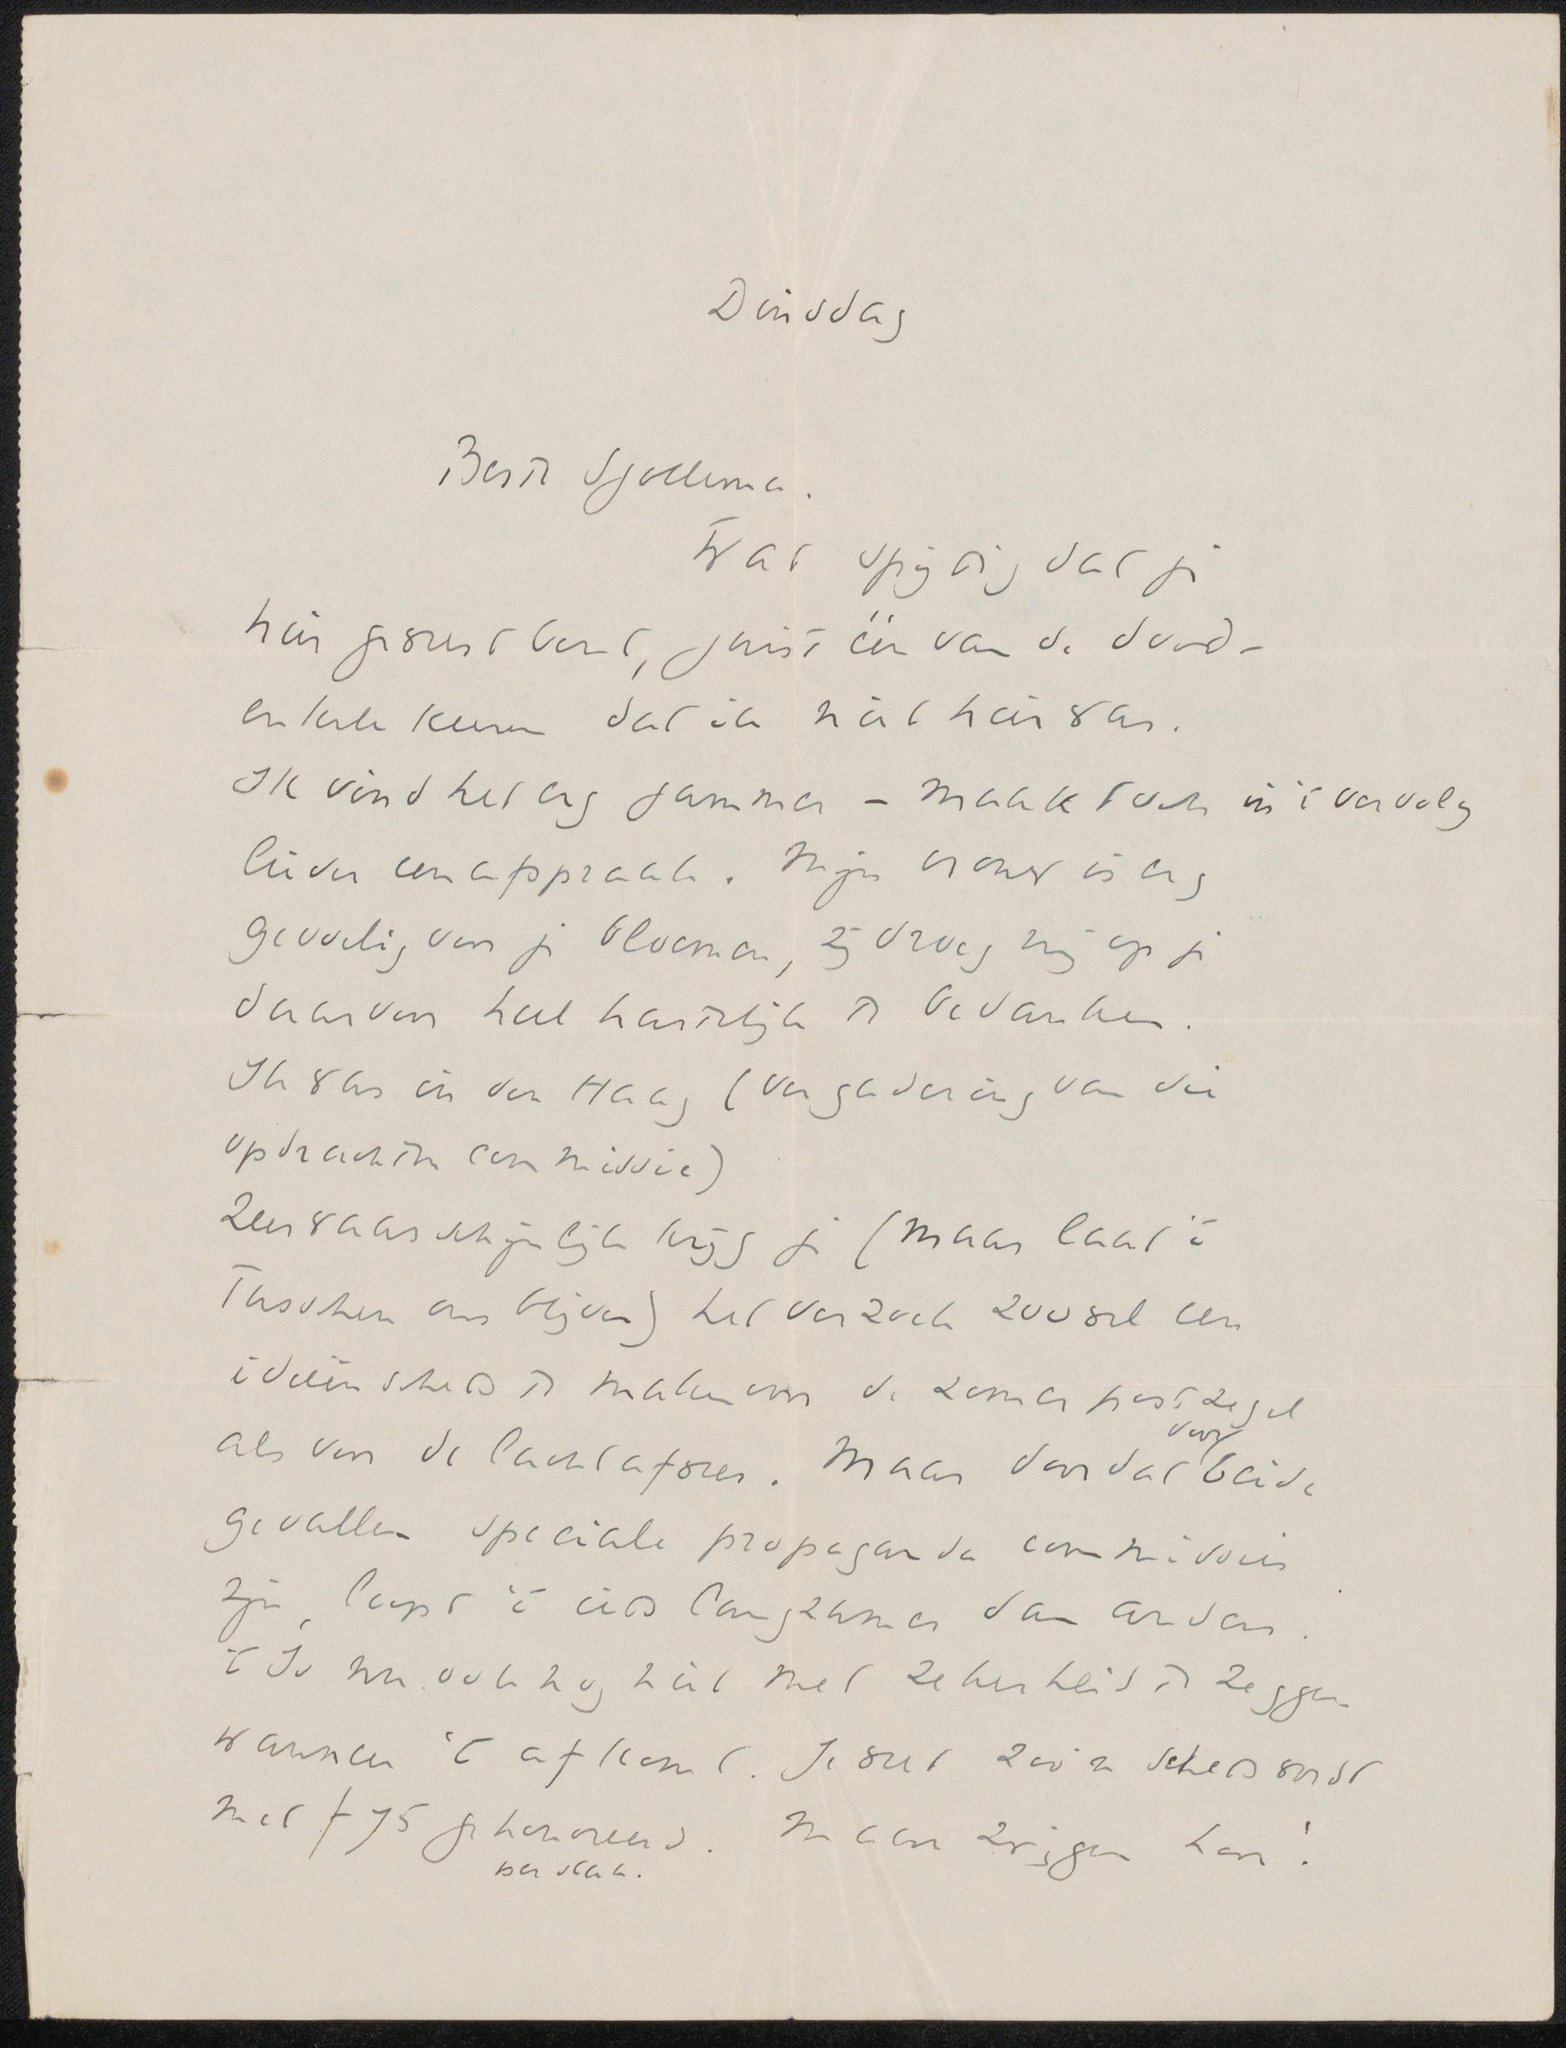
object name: letter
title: Brief aan Joop Sjollema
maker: richard nicolaüs roland holst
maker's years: 1868-1938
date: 1938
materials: ink, paper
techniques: pen, writing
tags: print maker, joop sjollema, berlin, massimo campigli, amsterdam, the hague, painter, draughtsman, anonymous historical person portrayed, workshop, studio of the artist (in general), money